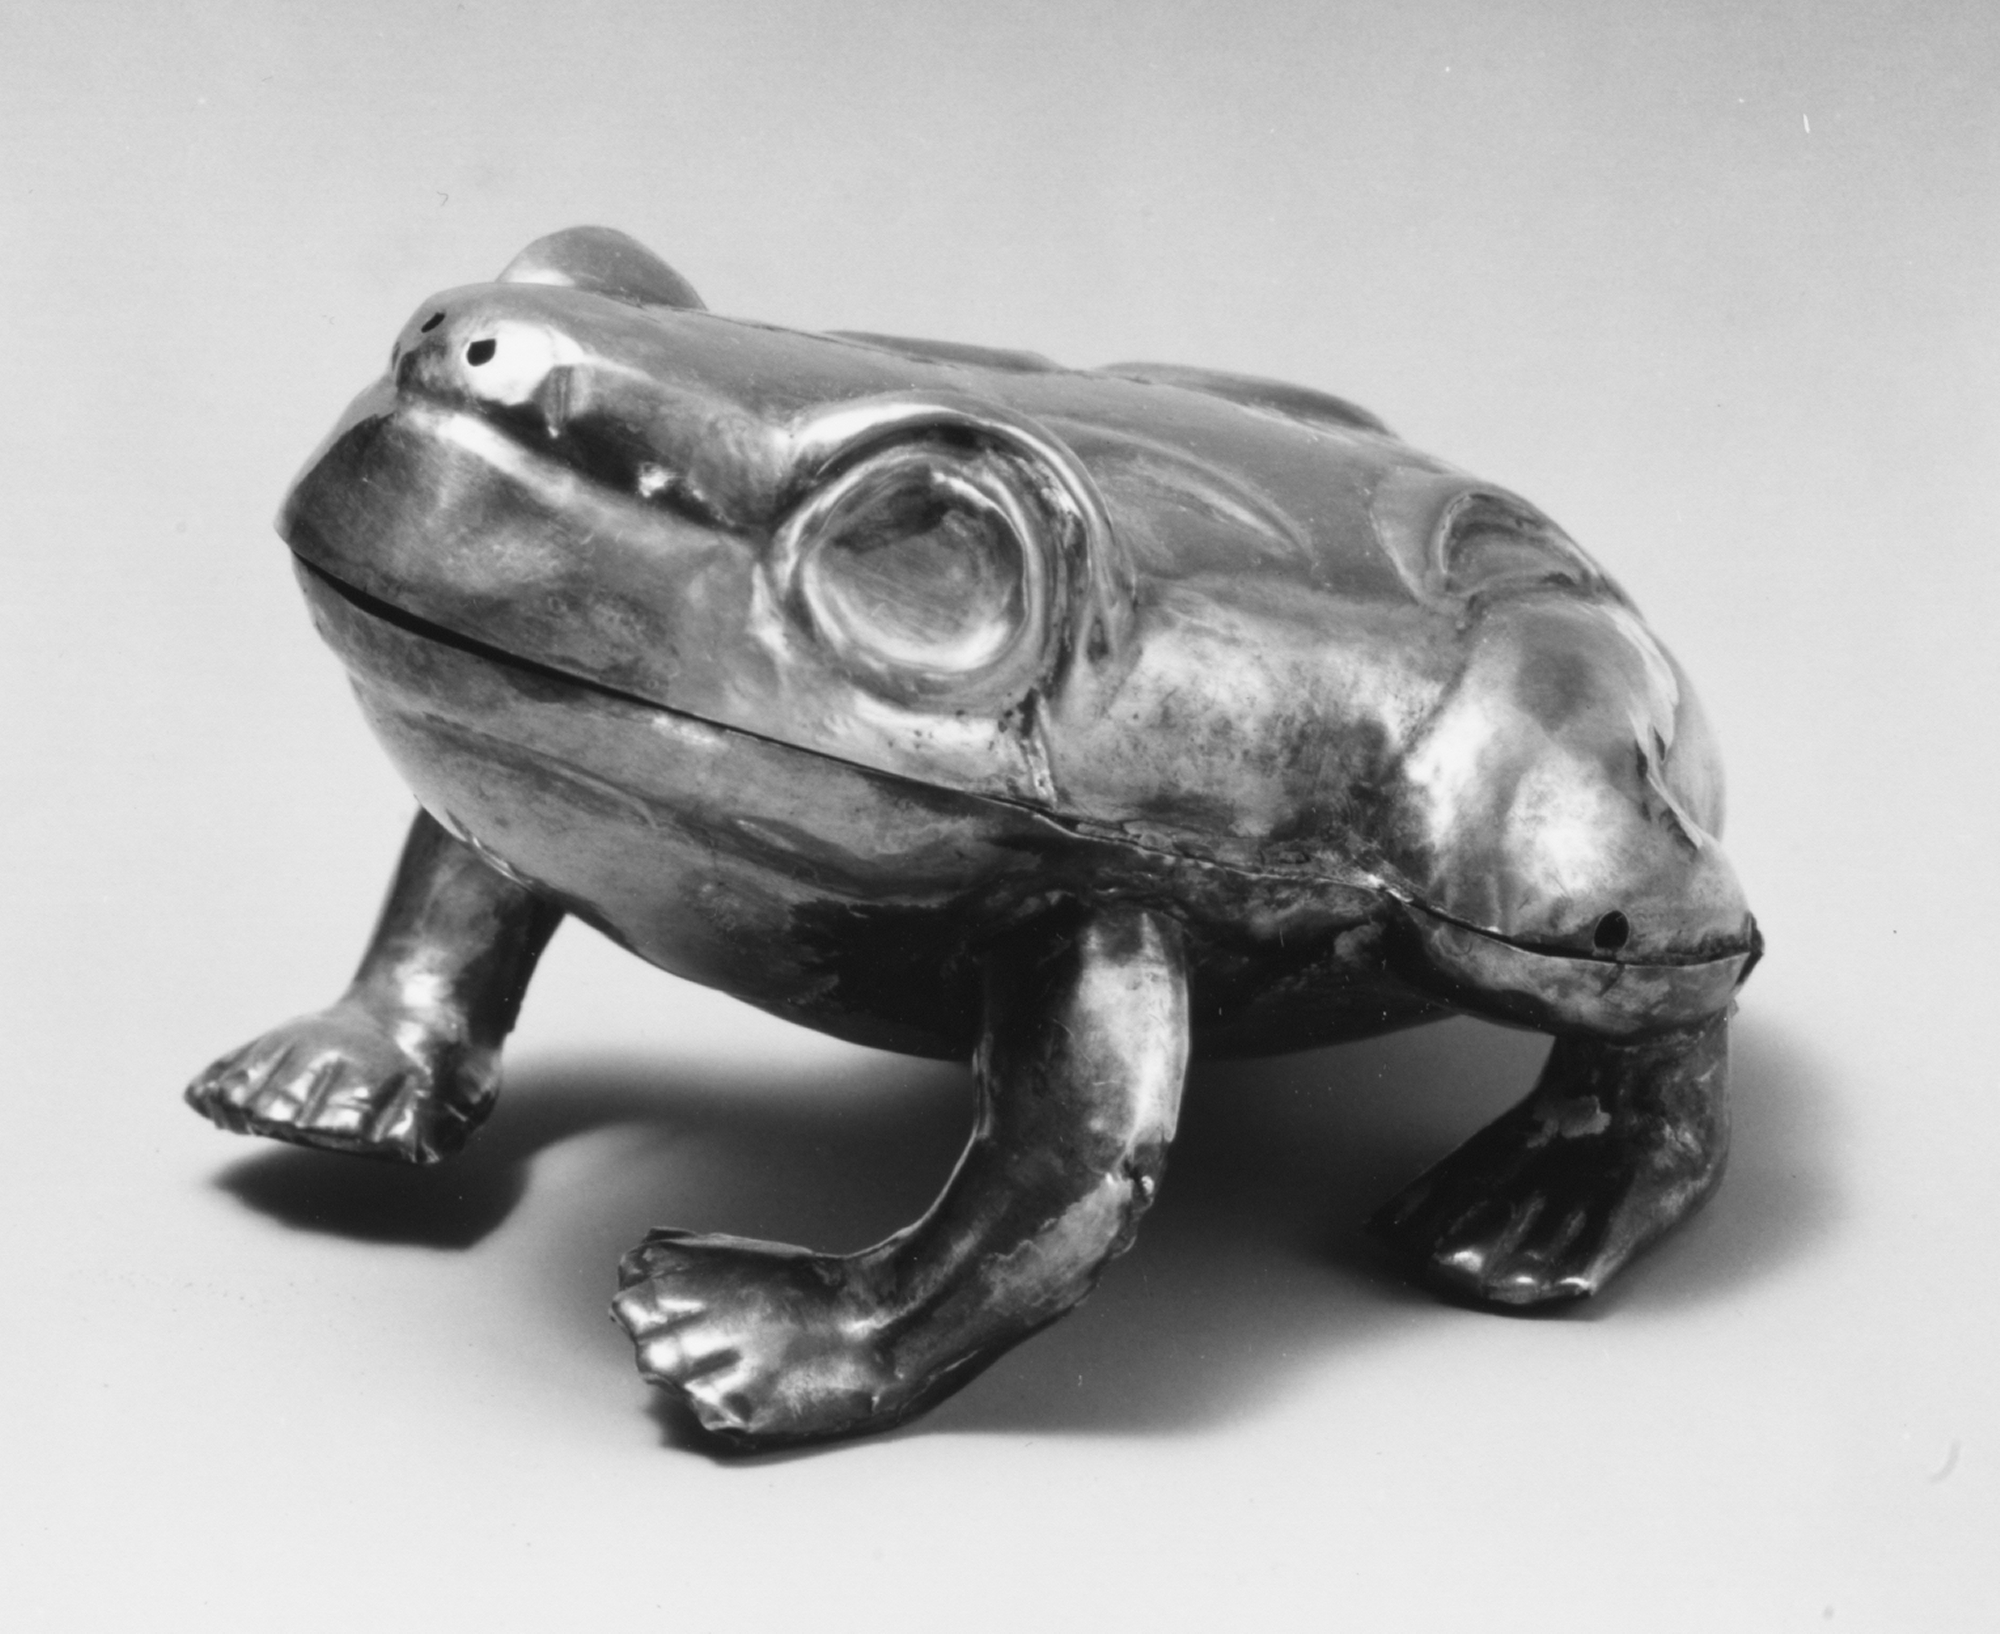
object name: necklace ornament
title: Frog Ornament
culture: moche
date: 101-600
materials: gold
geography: peru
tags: frogs